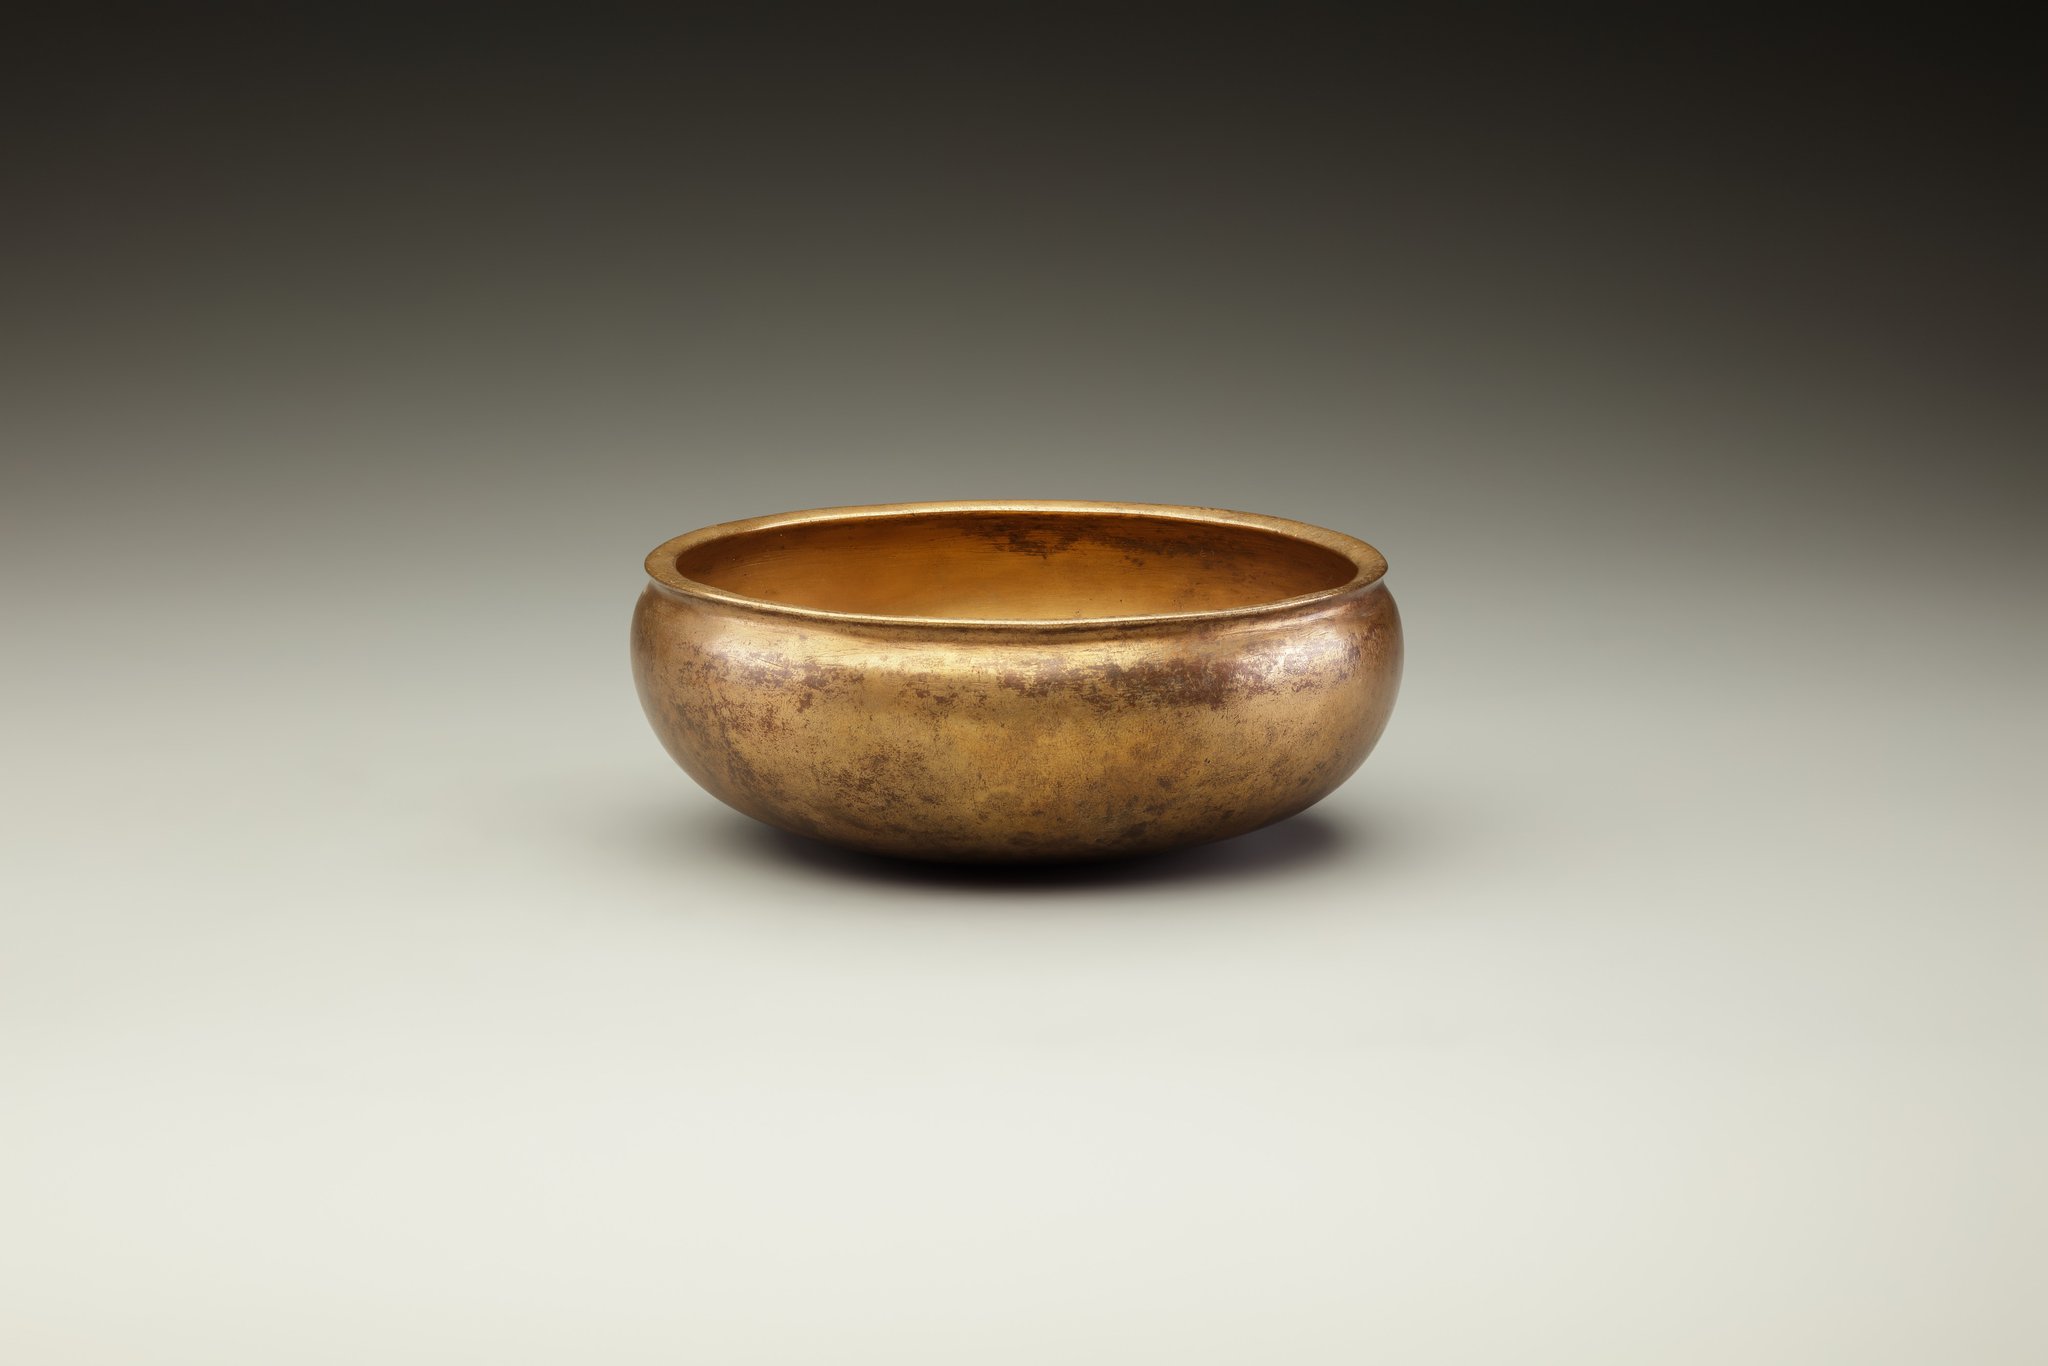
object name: bowl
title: One of five bowls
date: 1295-1070 BCE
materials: bronze, copper alloy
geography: egypt